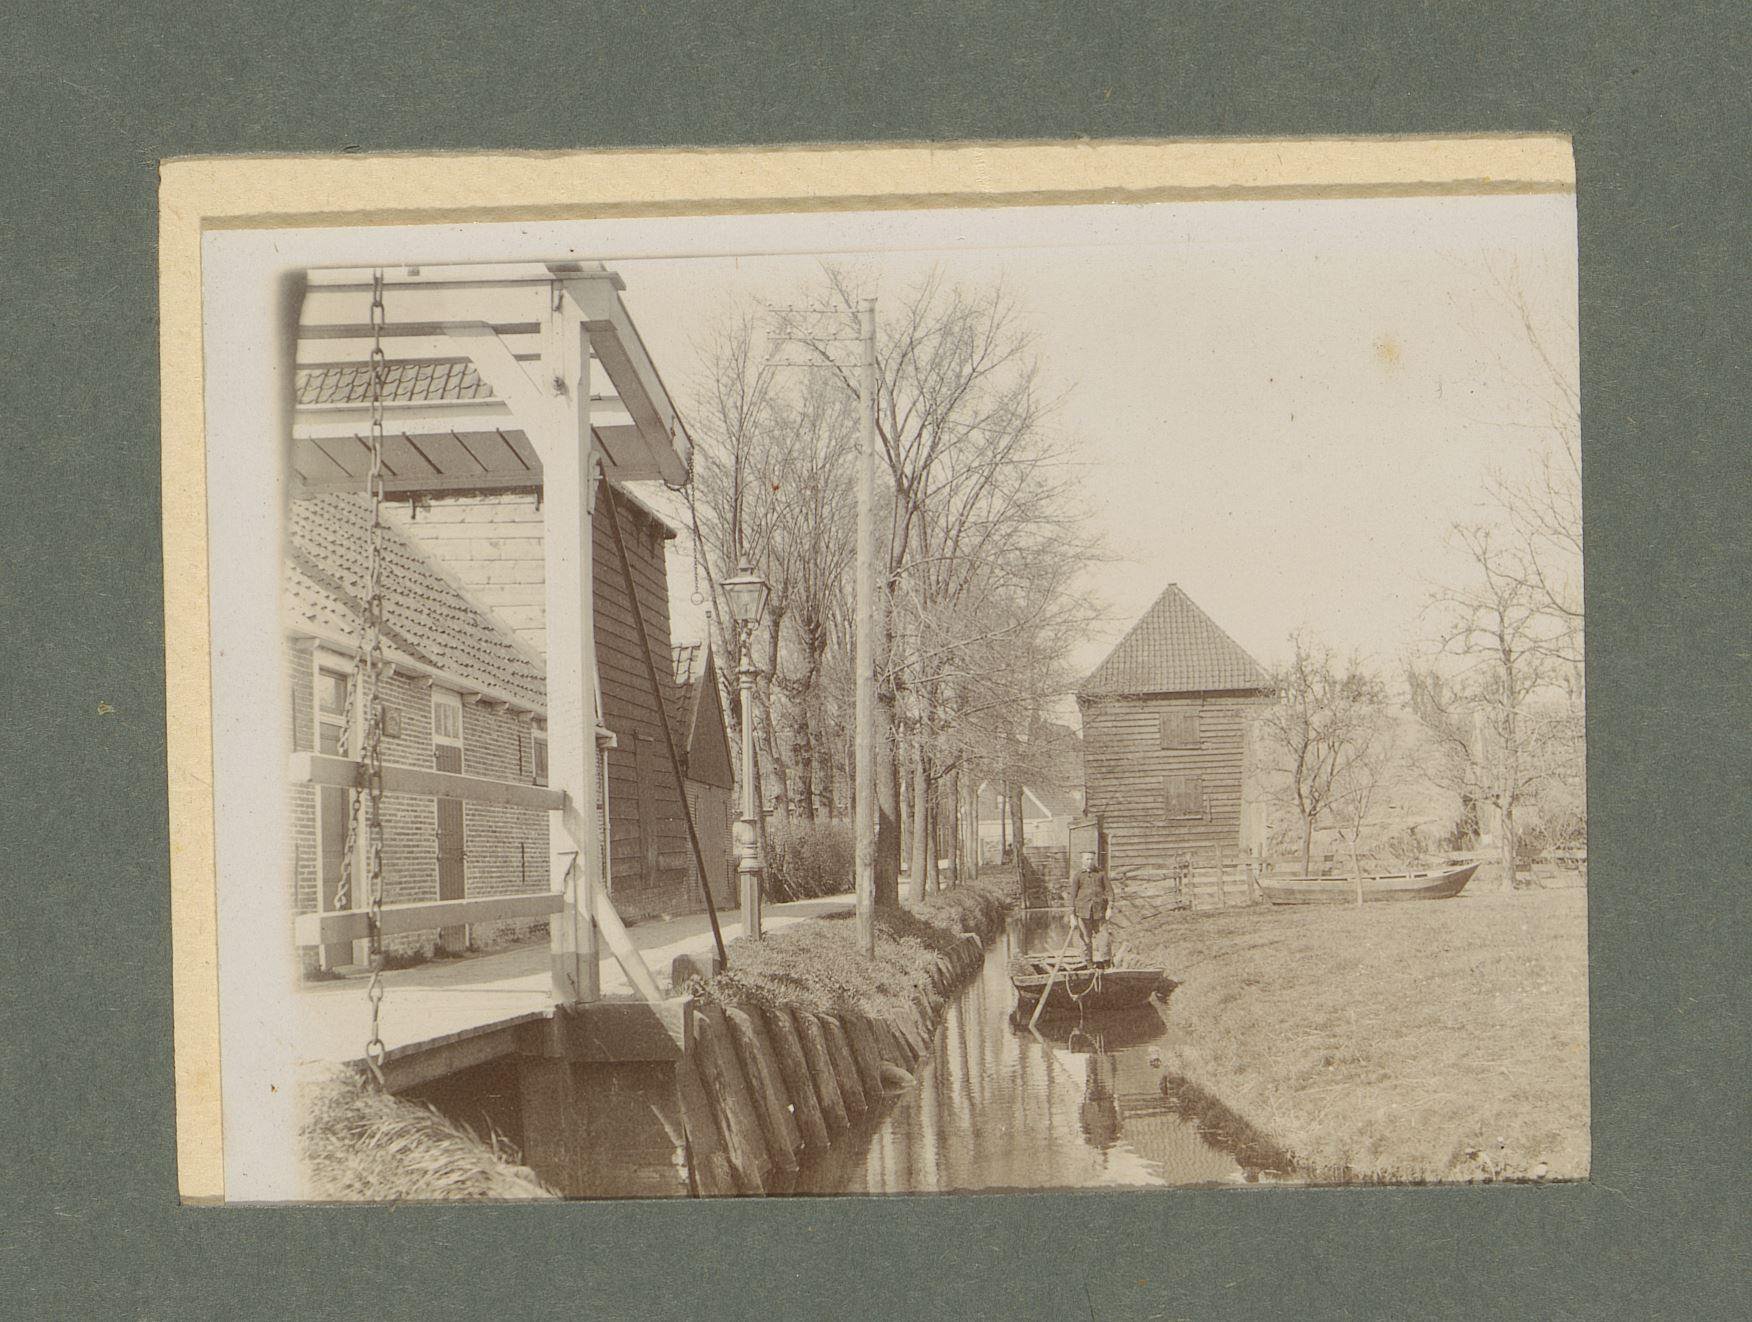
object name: album leaf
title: Gezicht op boot in een landschap met een sloot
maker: george hidderley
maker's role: fotograaf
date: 1920-1940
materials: photographic support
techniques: gelatin silver print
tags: landscapes with waters, waterscapes, seascapes (in the temperate zone), civic architecture; edifices; dwellings, boat propelled by man or animal